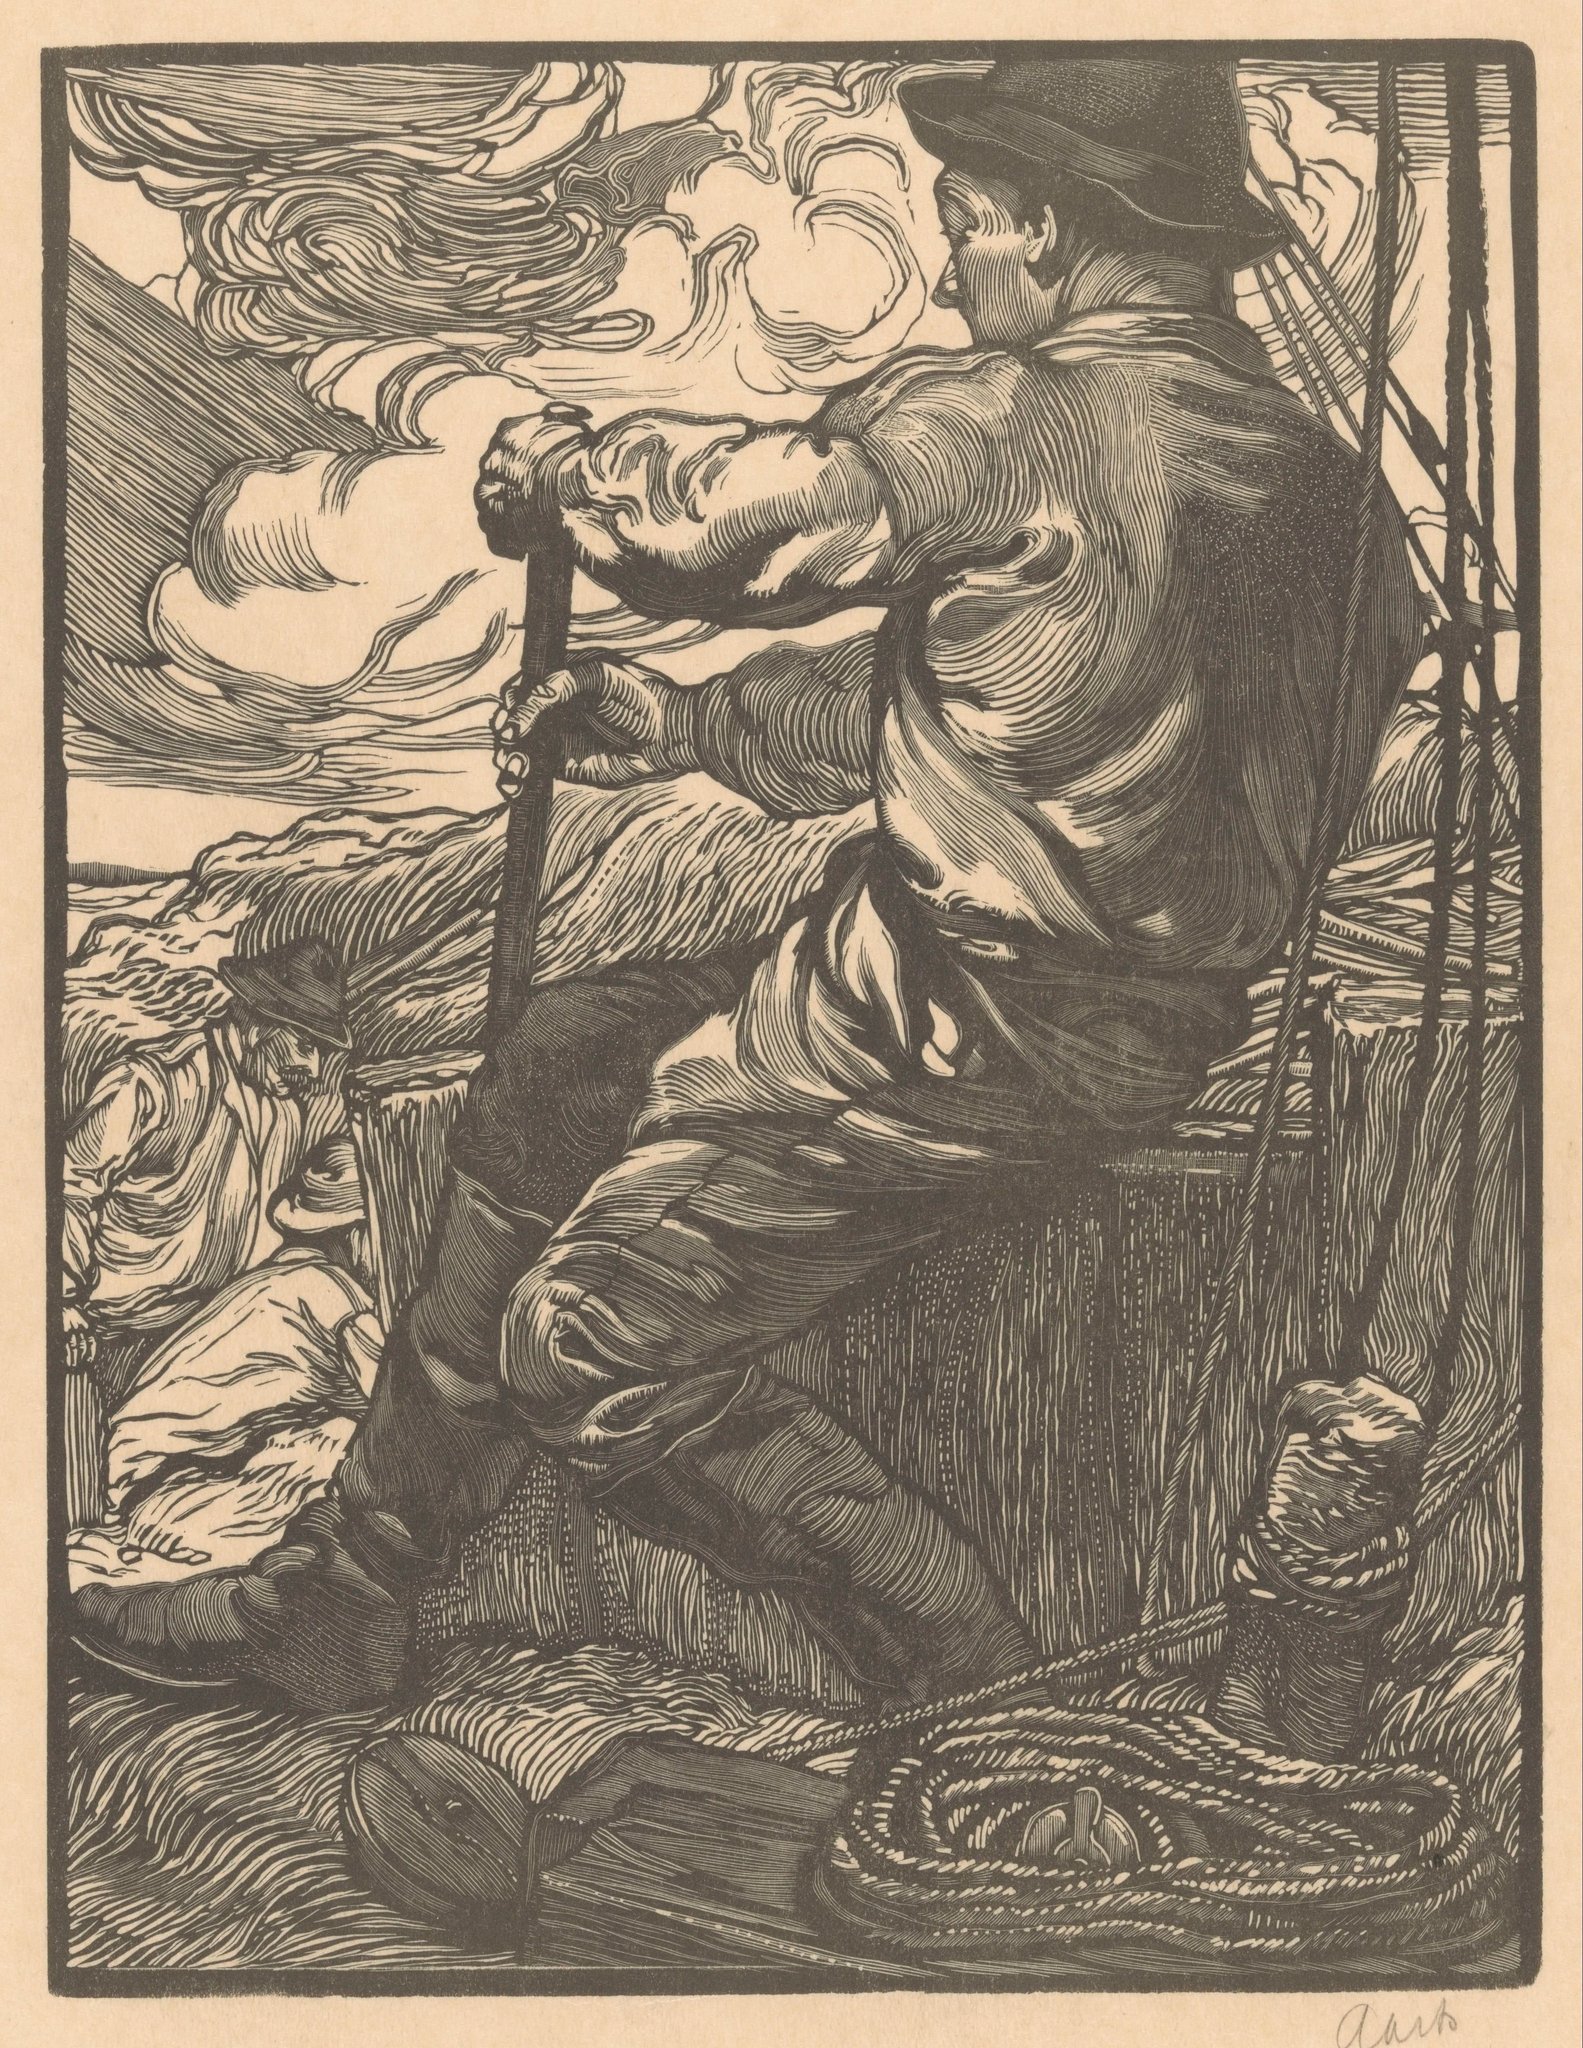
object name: print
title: Polderwerker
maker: johannes josephus aarts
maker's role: draughtsman, print maker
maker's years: 1871-1934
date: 1881-1934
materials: paper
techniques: woodcut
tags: working class, labourers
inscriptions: collector's mark: Lugt 2228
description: Een man wrikt met een staaf in een rij balken. Hij draagt een hoed en hoge laarzen. Links op de achtergrond nog twee arbeiders.